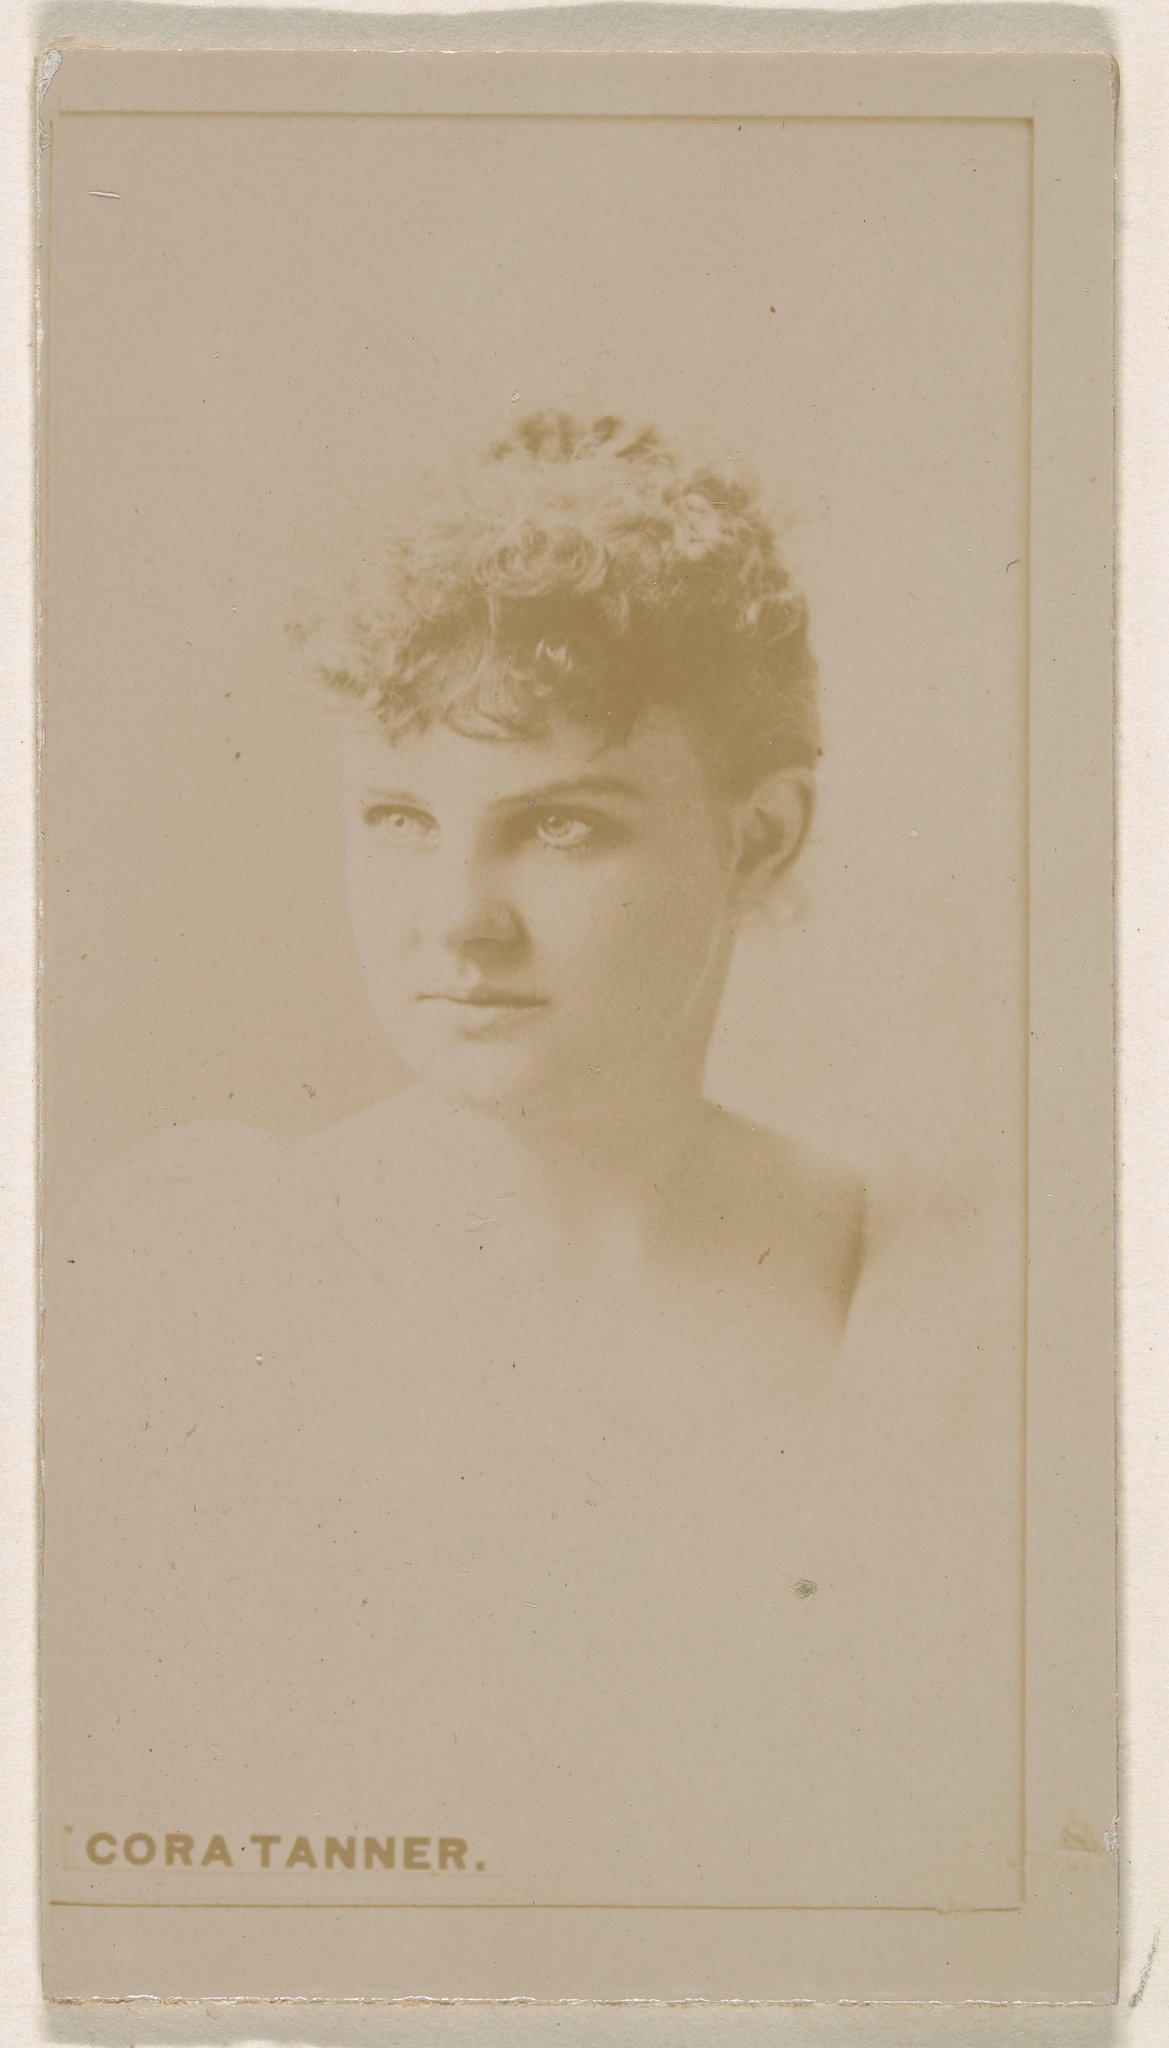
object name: photograph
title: Cora Tanner, from the Actresses series (N245) issued by Kinney Brothers to promote Sweet Caporal Cigarettes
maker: kinney brothers tobacco company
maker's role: publisher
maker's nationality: american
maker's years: 1869-2011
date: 1890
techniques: albumen silver print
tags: portraits,women,actresses